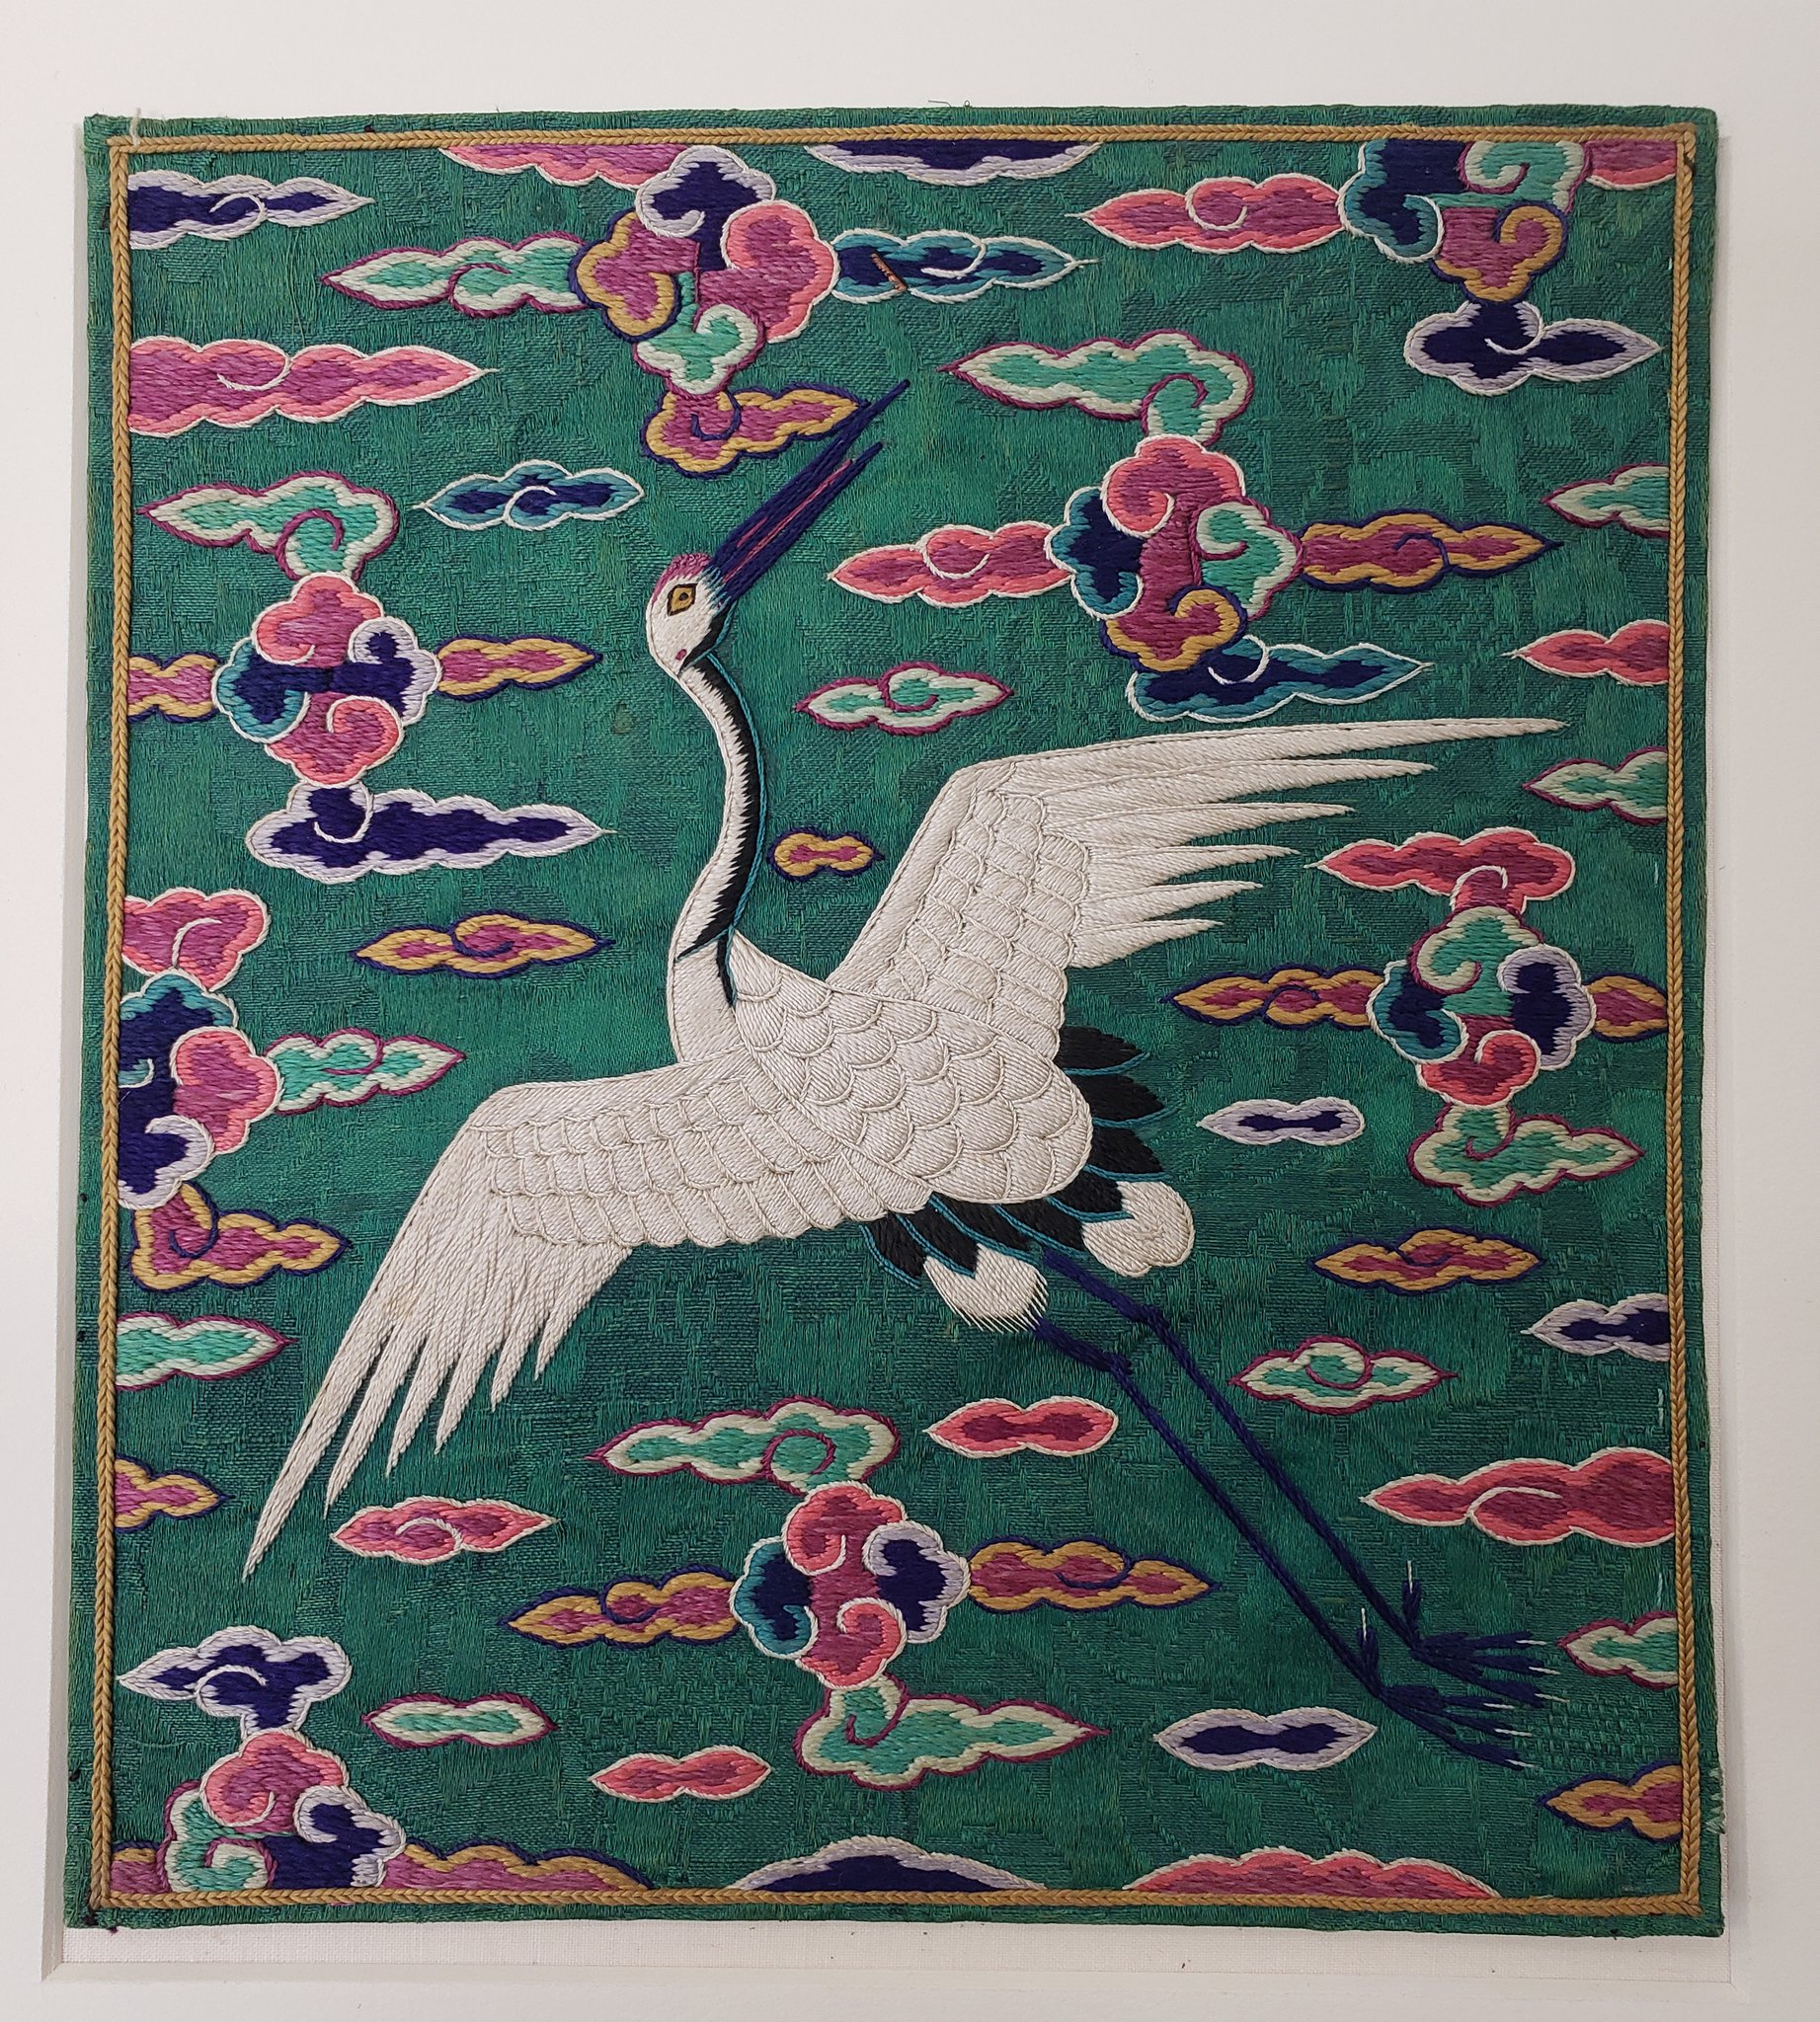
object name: rank badge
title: Civil-Official Hyungbae (Rank Badge)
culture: korean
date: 1867-1900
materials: silk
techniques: damask, embroidery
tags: cranes